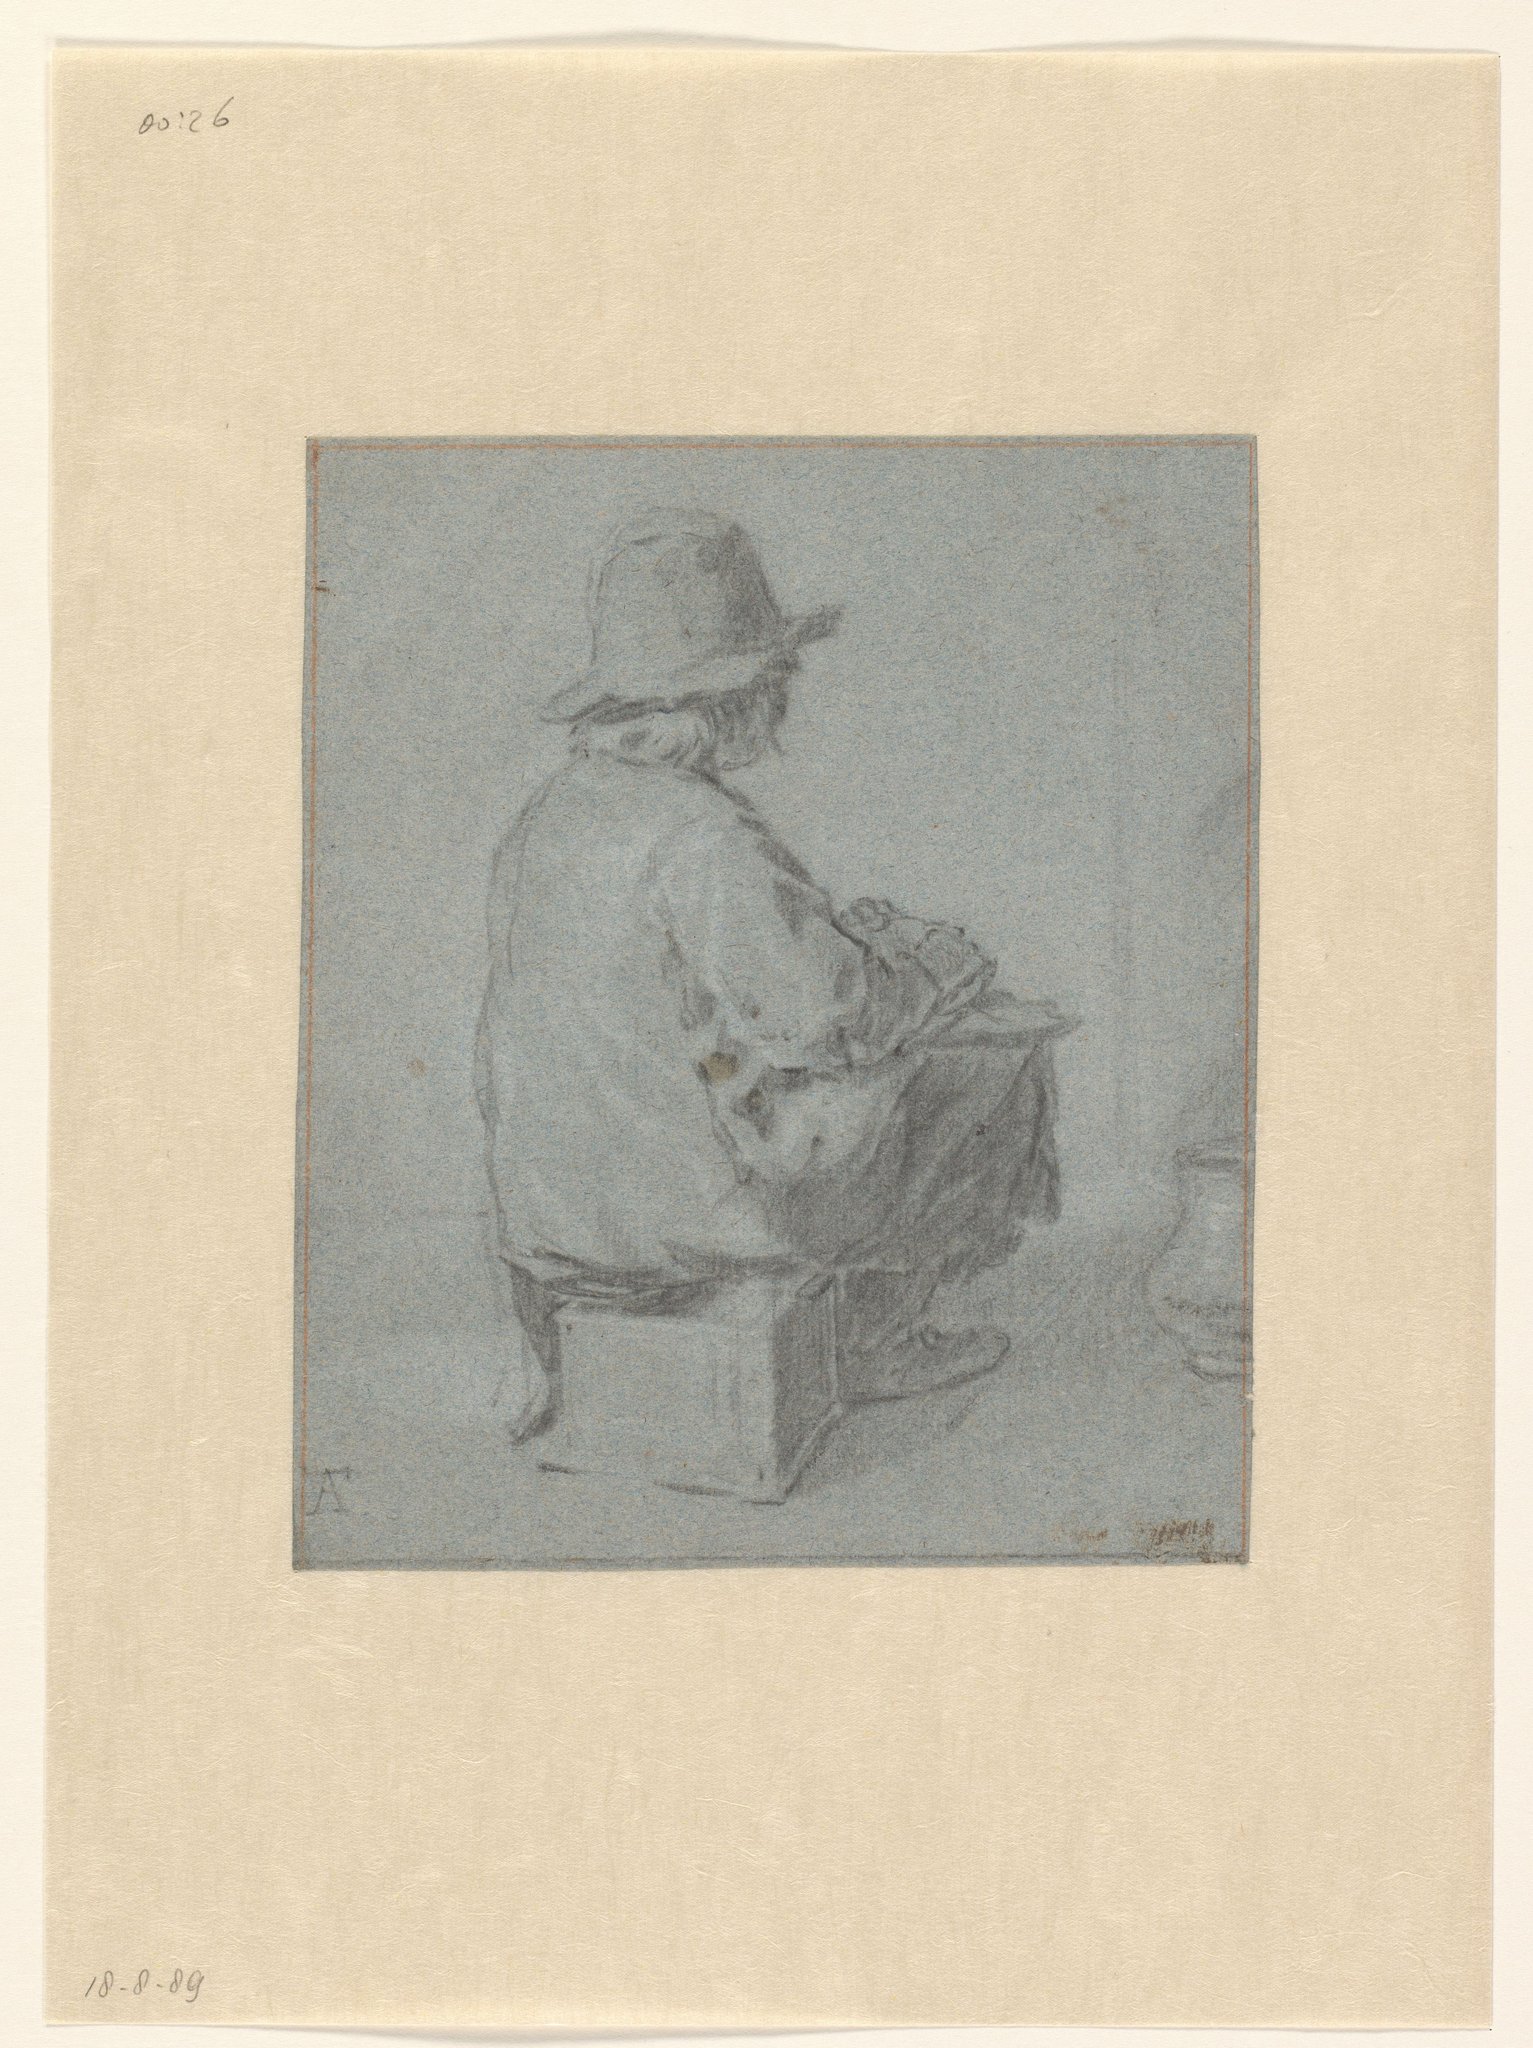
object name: drawing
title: Jongen, zittend op een stoof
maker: monogrammist at of af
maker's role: draughtsman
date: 1600-1699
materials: chalk, paper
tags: sitting figure, boy (child between toddler and youth)